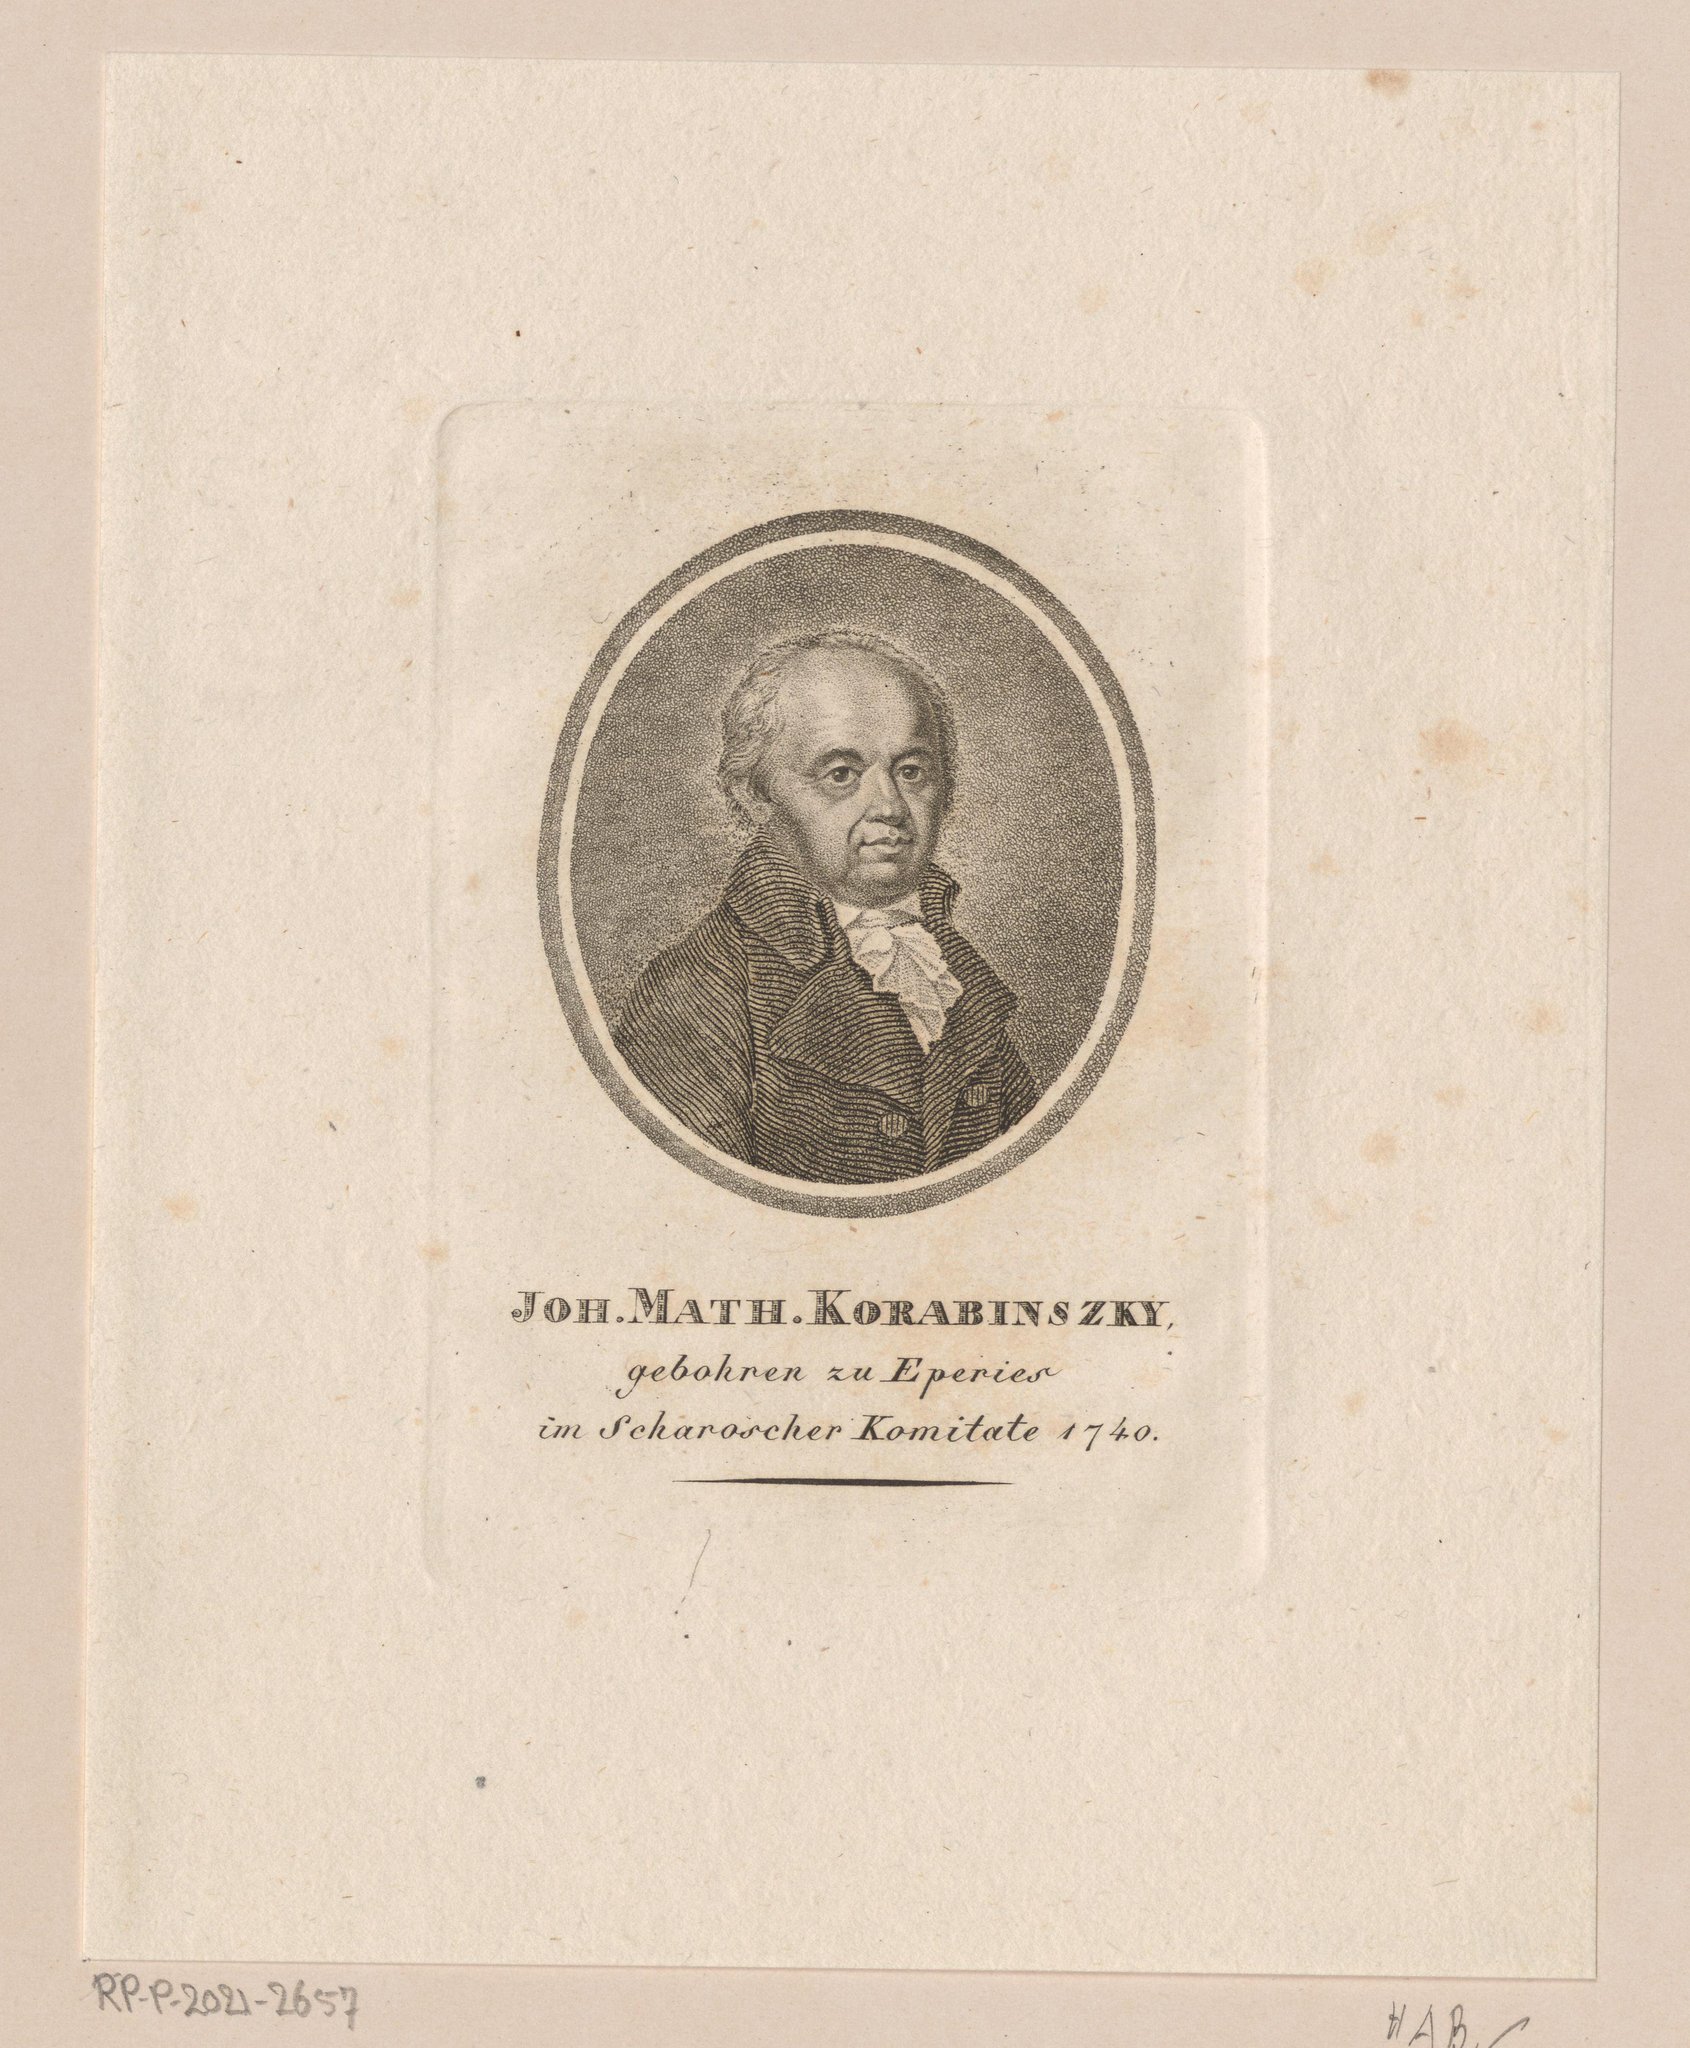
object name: print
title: Portret van Johann Matthias Korabinszky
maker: Anonymous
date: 1806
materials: paper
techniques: etching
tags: historical persons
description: Prent mogelijk uit: Bertuch, Friedrich Justin. Allgemeine geographische Ephemeriden. Wiemar: Verlage des Landes-Industrie-Comptoirs, 1806, dl. 21.